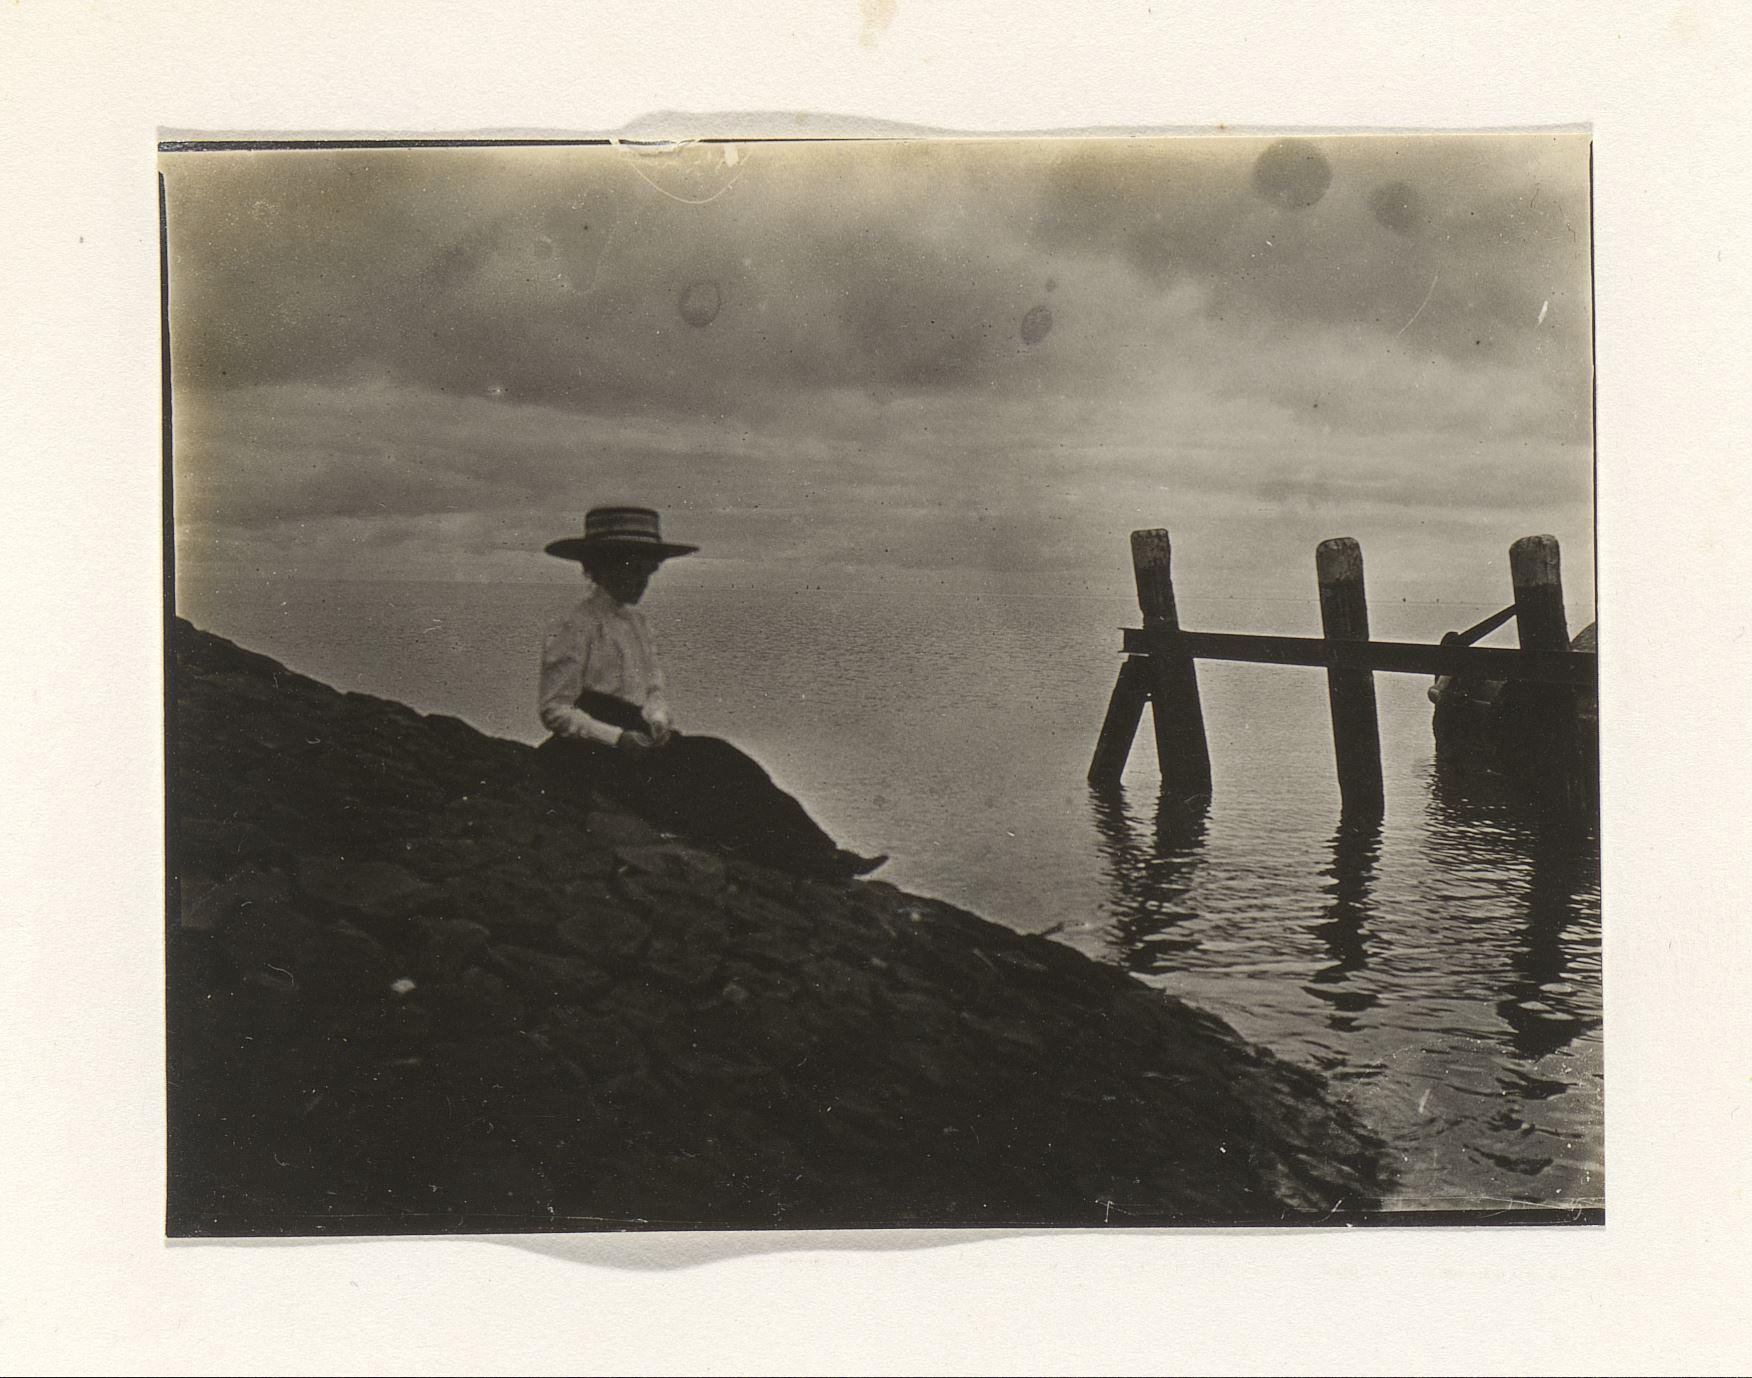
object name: photograph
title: Vrouw aan een water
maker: george hidderley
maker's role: fotograaf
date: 1900-1910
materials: paper, photographic support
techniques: gelatin silver print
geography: volendam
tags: adult woman, historical persons, landscapes with waters, waterscapes, seascapes (in the temperate zone)